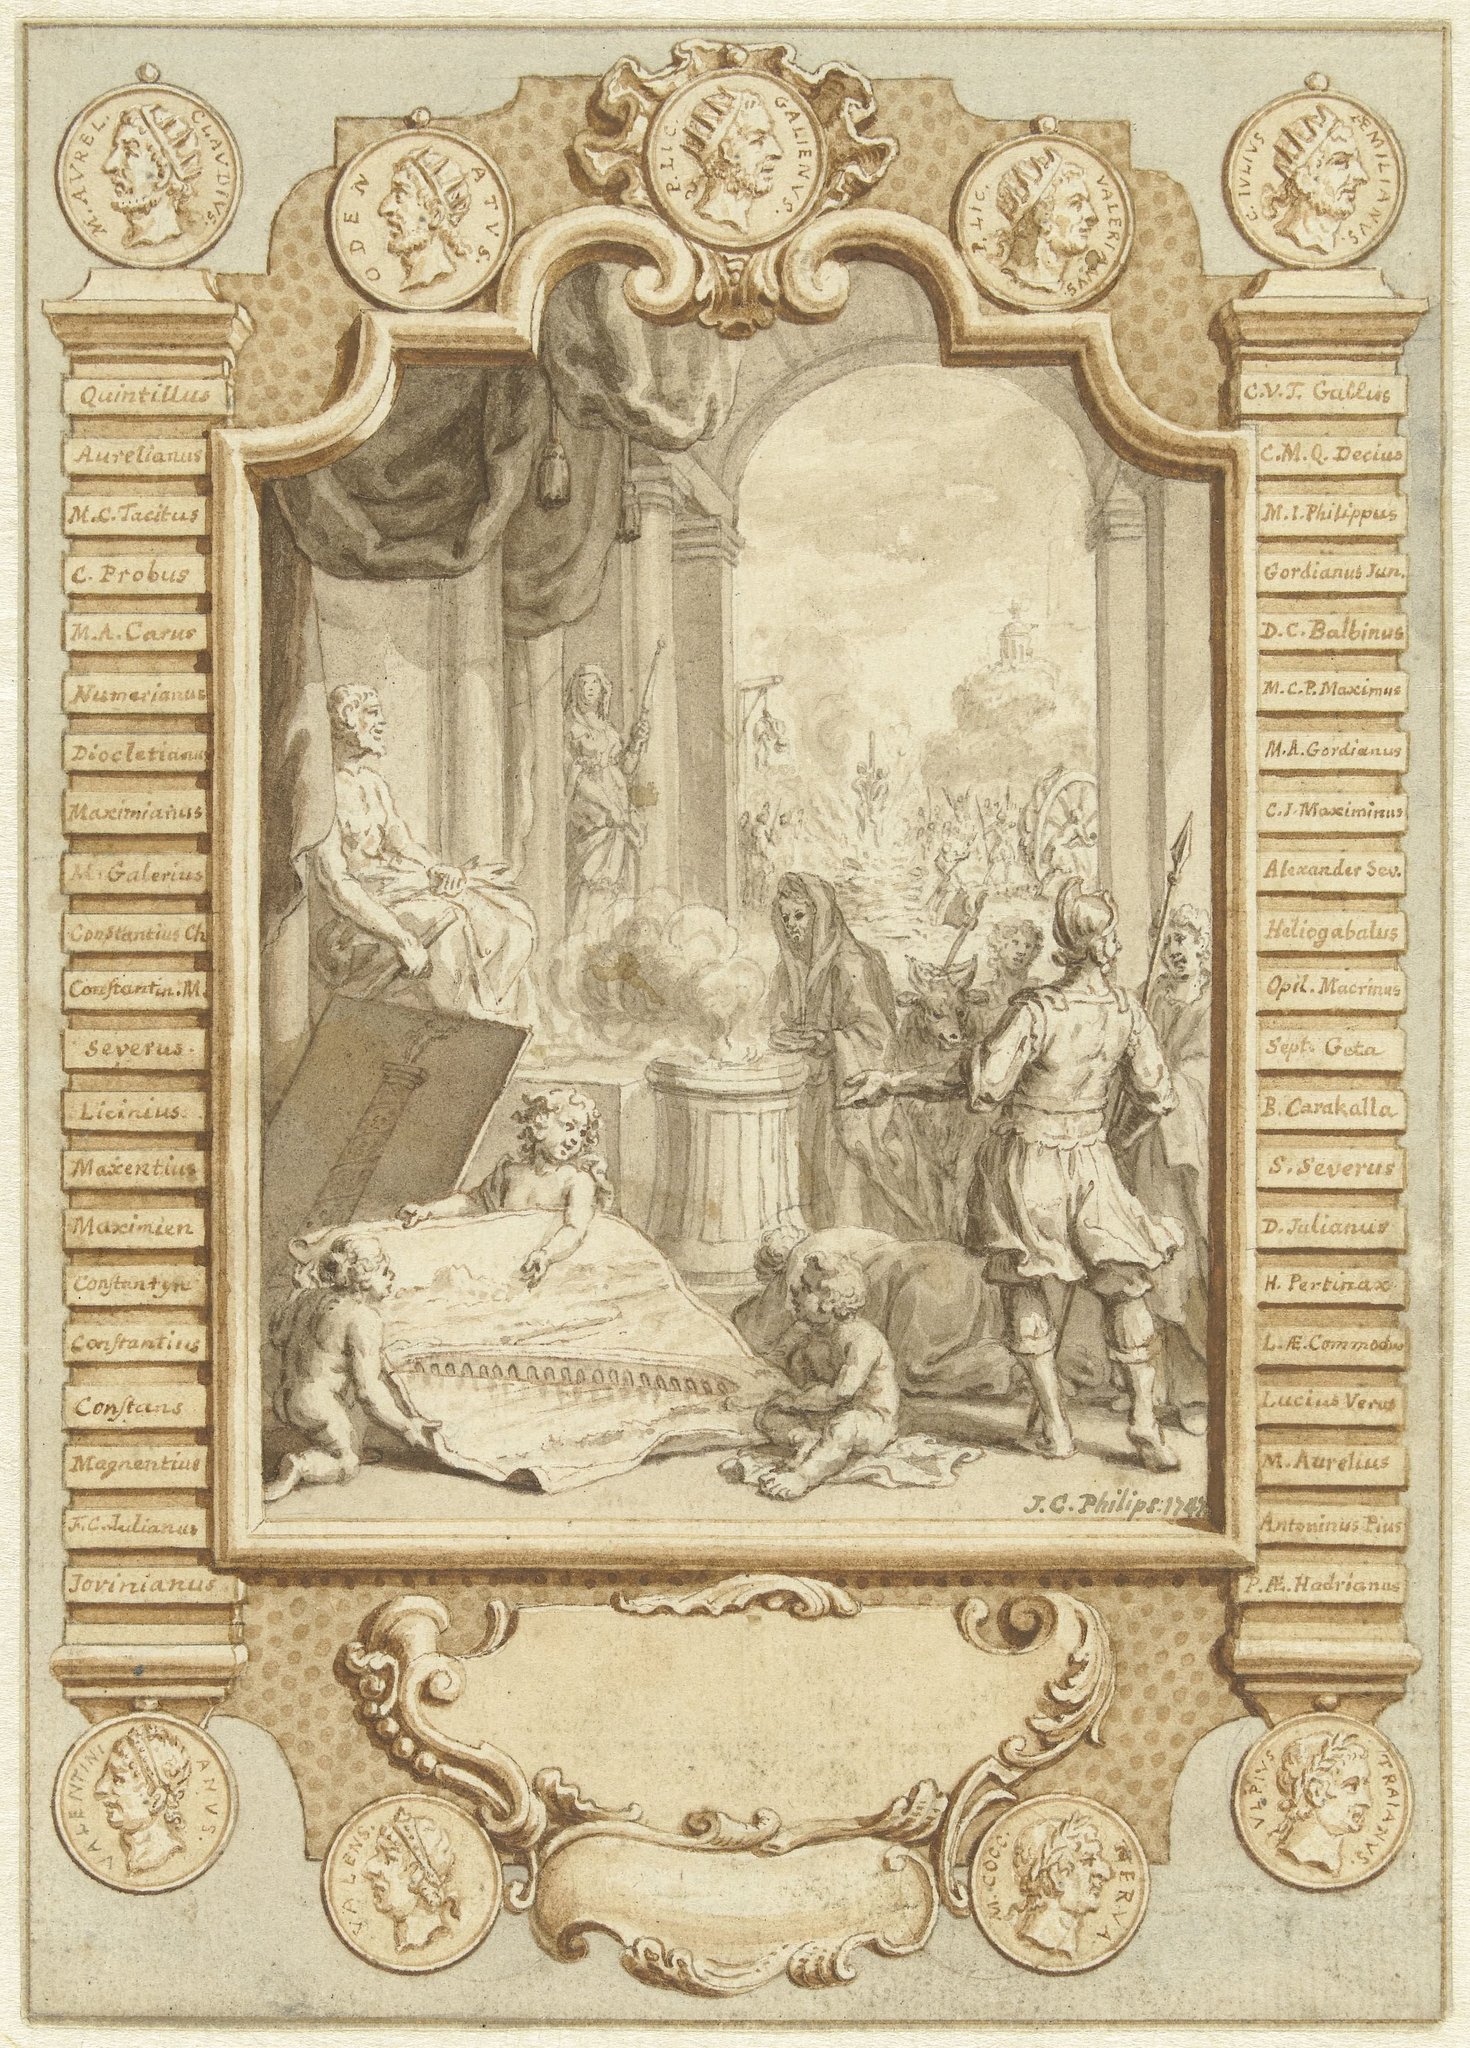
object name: drawing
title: Ontwerp voor titelpagina voor Algemene Historie van het begin der wereld af, deel XIII, 1747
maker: jan caspar philips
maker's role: draughtsman, print maker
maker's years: 1700-1775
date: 1747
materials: ink, paper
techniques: brush, pen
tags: 'historia'; 'historia' (ripa)